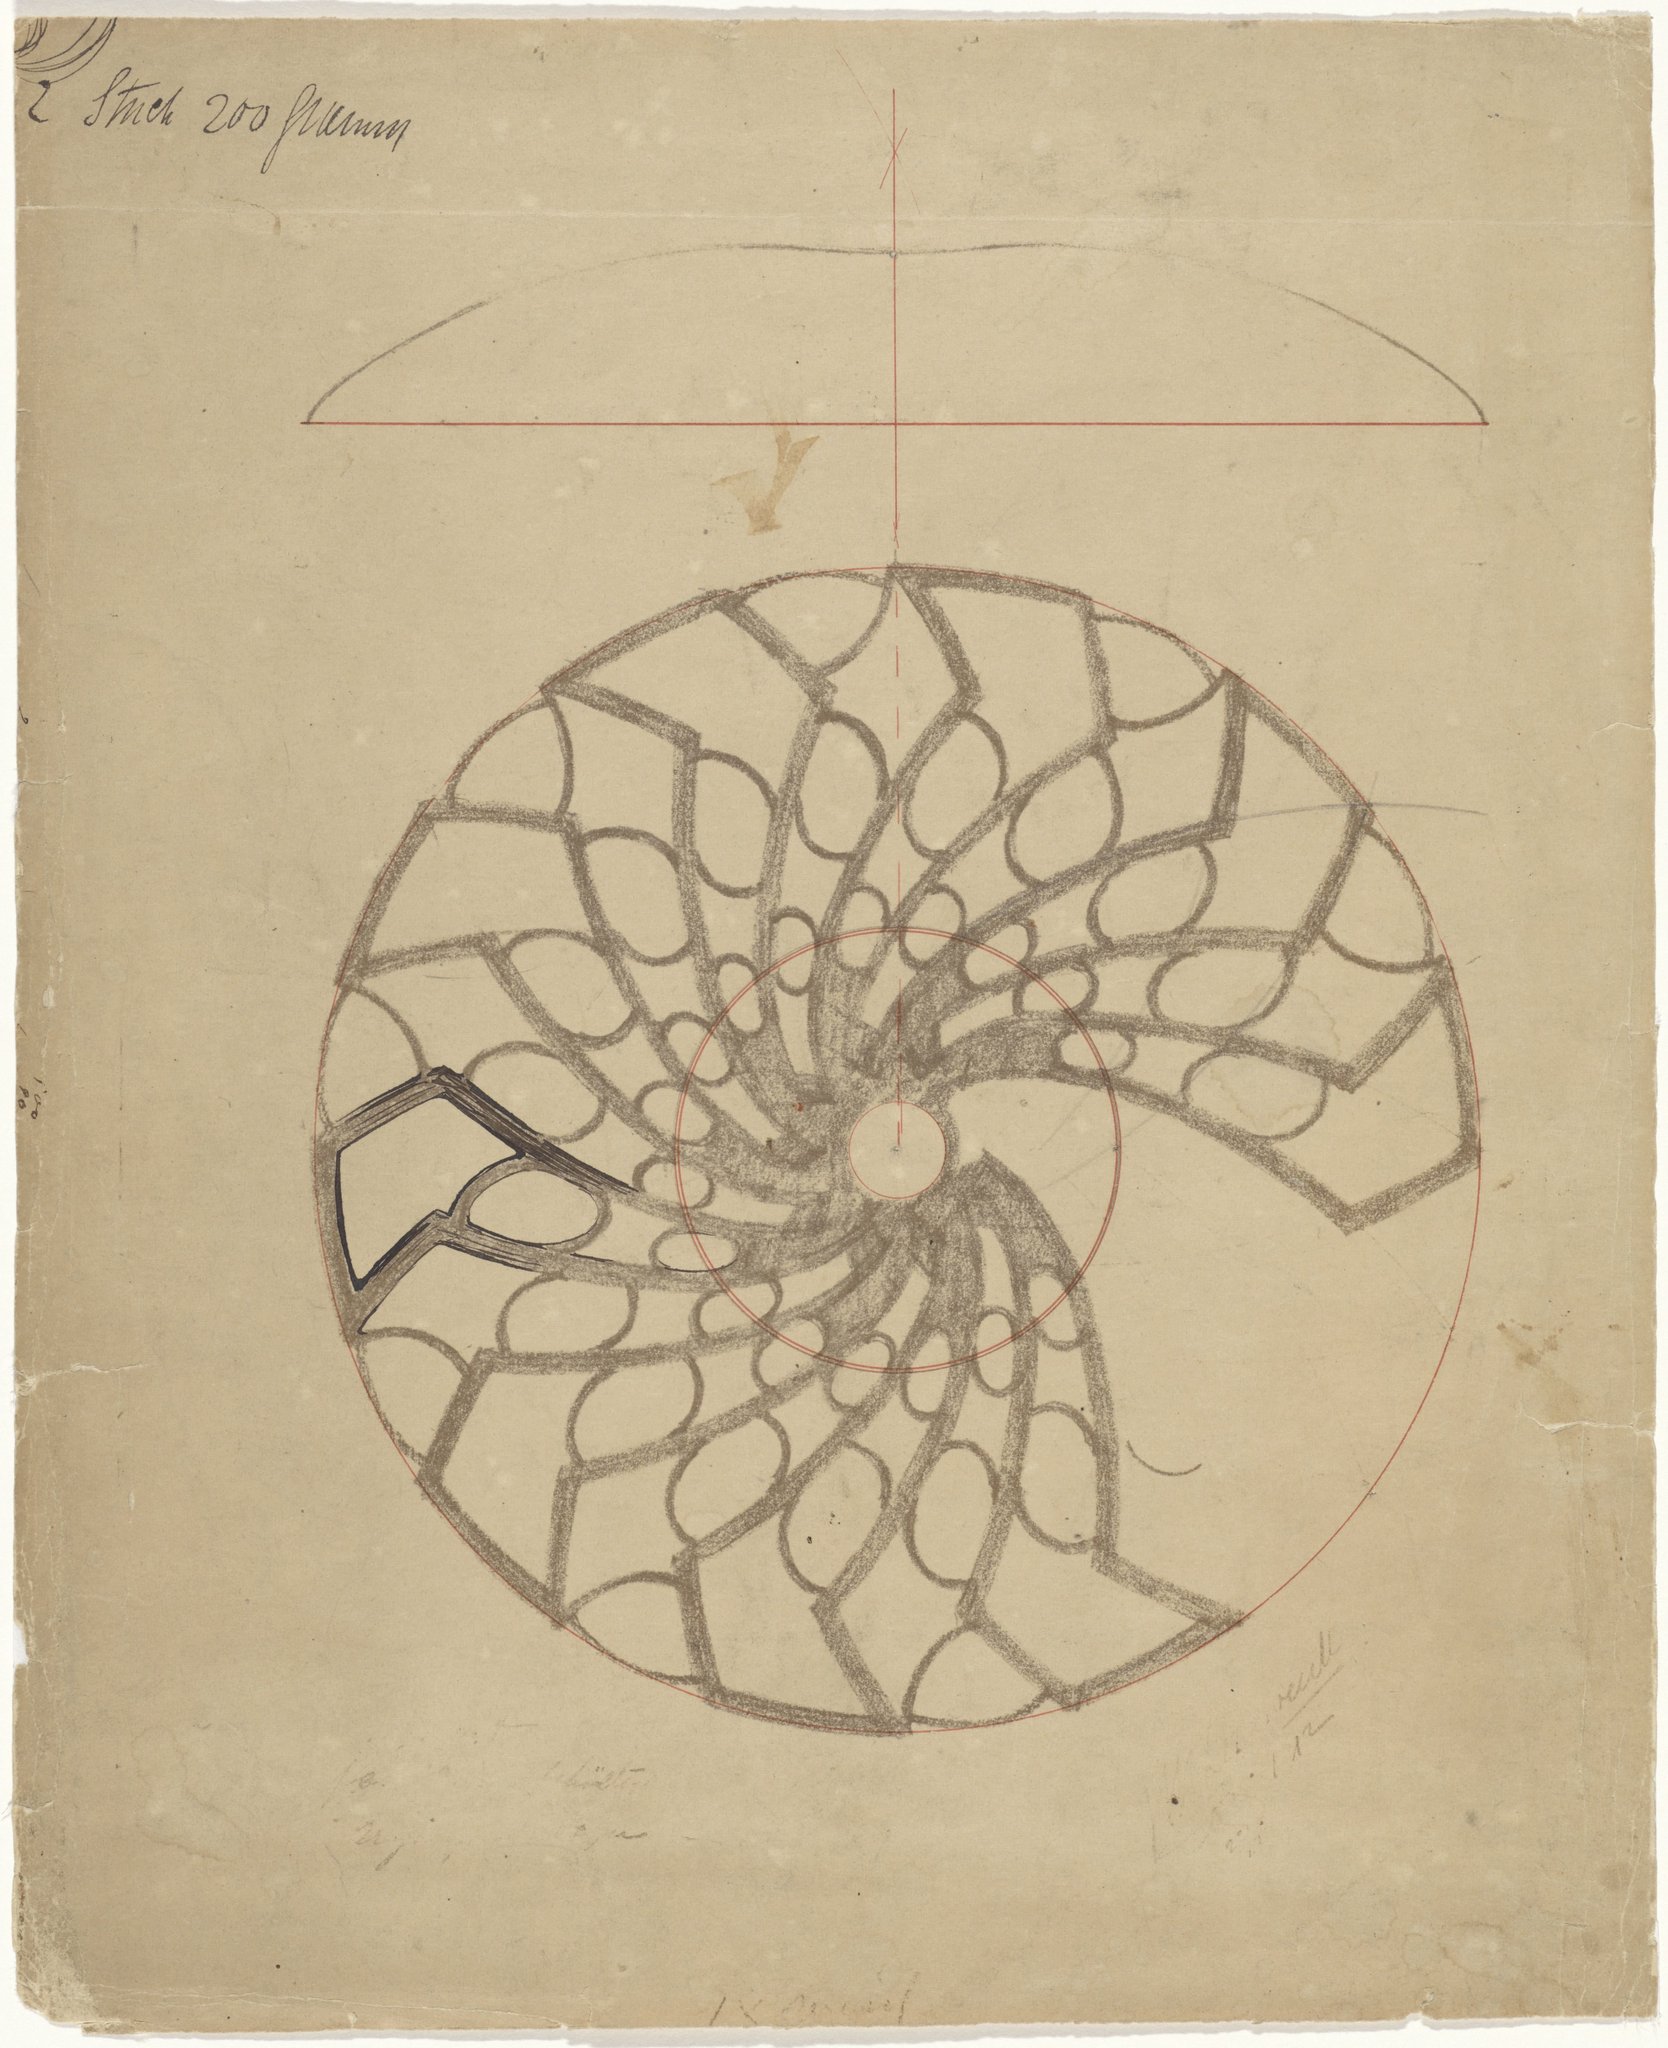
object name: photograph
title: Ontwerp voor een hangende lamp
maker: mathieu lauweriks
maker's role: designer, draughtsman, print maker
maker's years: 1864-1932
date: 1874-1932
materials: ink, paper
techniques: blueprint, pen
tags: gas-lamp, electric lamp